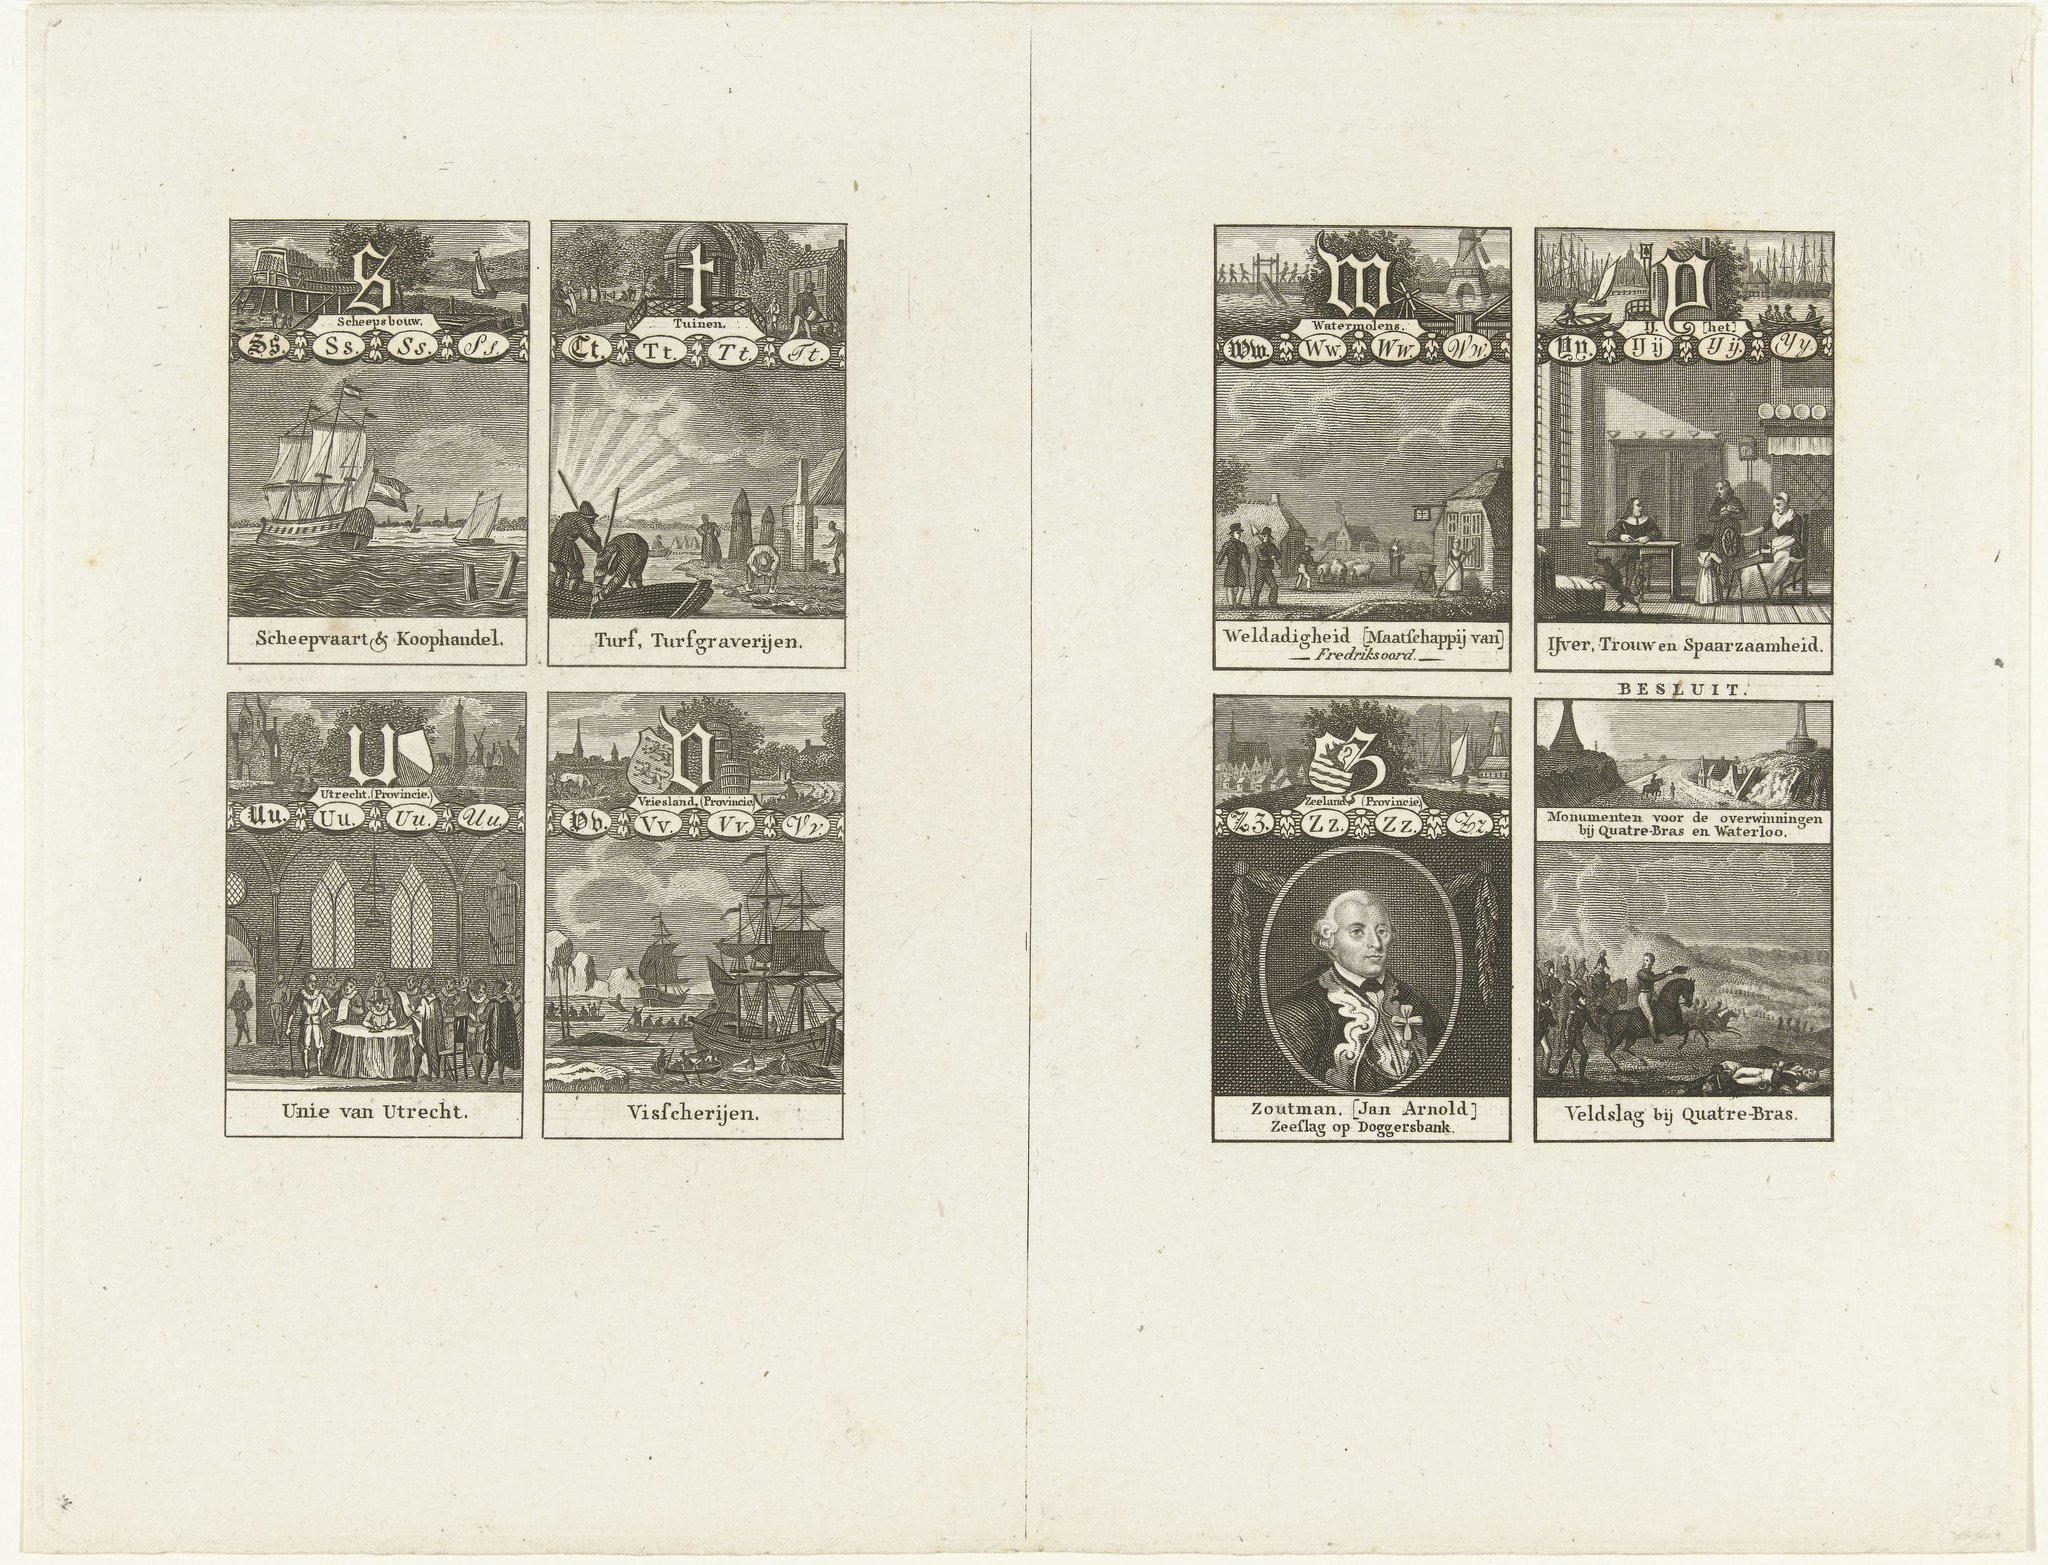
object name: print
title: Blad S/T/U/V en blad W/IJ/Z en besluit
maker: philippus velijn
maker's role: print maker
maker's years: 1787-1836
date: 1821-1823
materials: paper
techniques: engraving, etching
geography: netherlands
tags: johan arnold zoutman, netherlands, union of utrecht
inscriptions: collector's mark: Lugt 2228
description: Blad voor de letters S: Scheepvaart en Koophandel, T: Turf en turfgraverijen, U: Unie van Utrecht, V: Visserij, W: Maatschappij van Weldadigheid, IJ: IJver, Trouw en Spaarzaamheid, Z: Jan Arnold Zoutman en de Slag bij de Doggersbank. Bij Besluit: Veldslag bij Quatre-Bras en Waterloo.